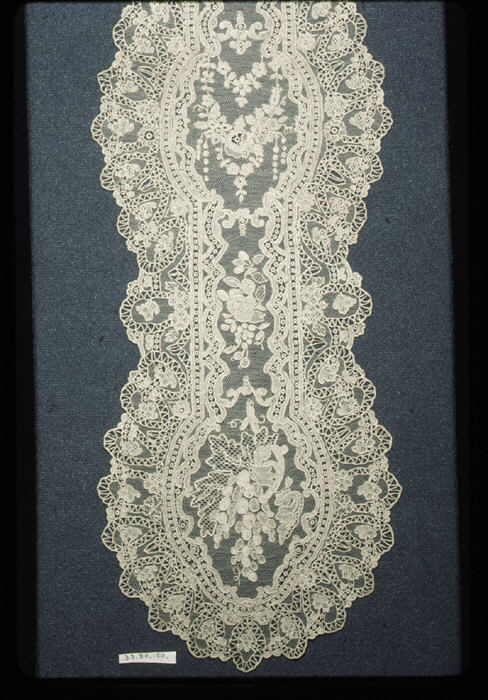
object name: lappet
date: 1860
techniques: lace